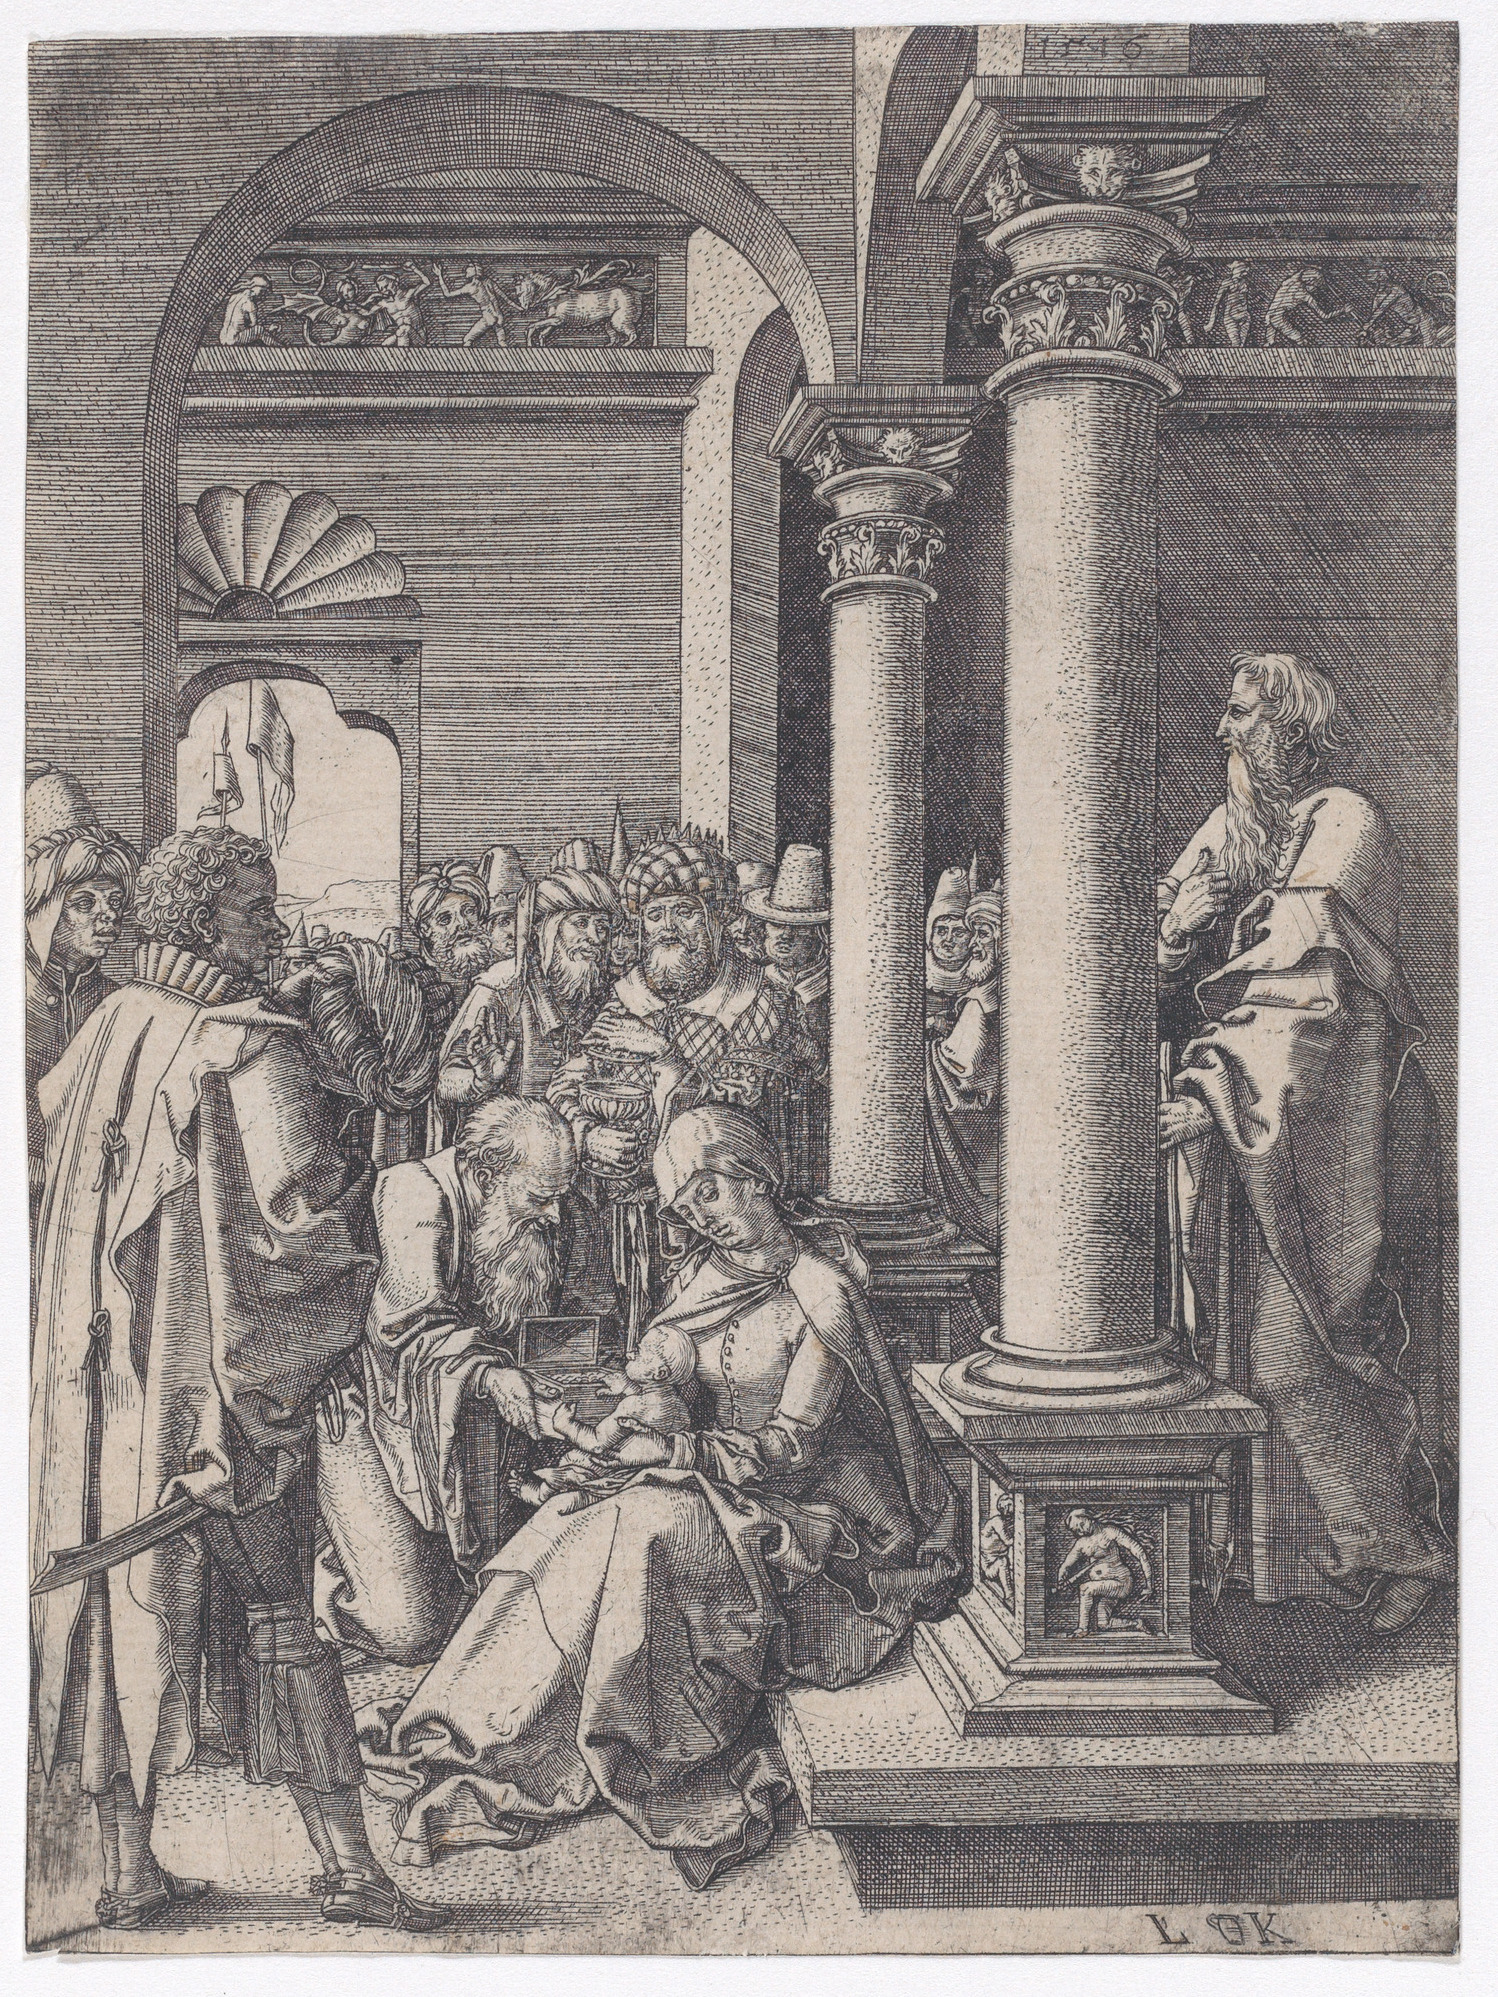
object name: print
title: The Adoration of the Magi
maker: ludwig krug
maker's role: artist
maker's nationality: german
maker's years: 1483-1532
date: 1516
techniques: engraving